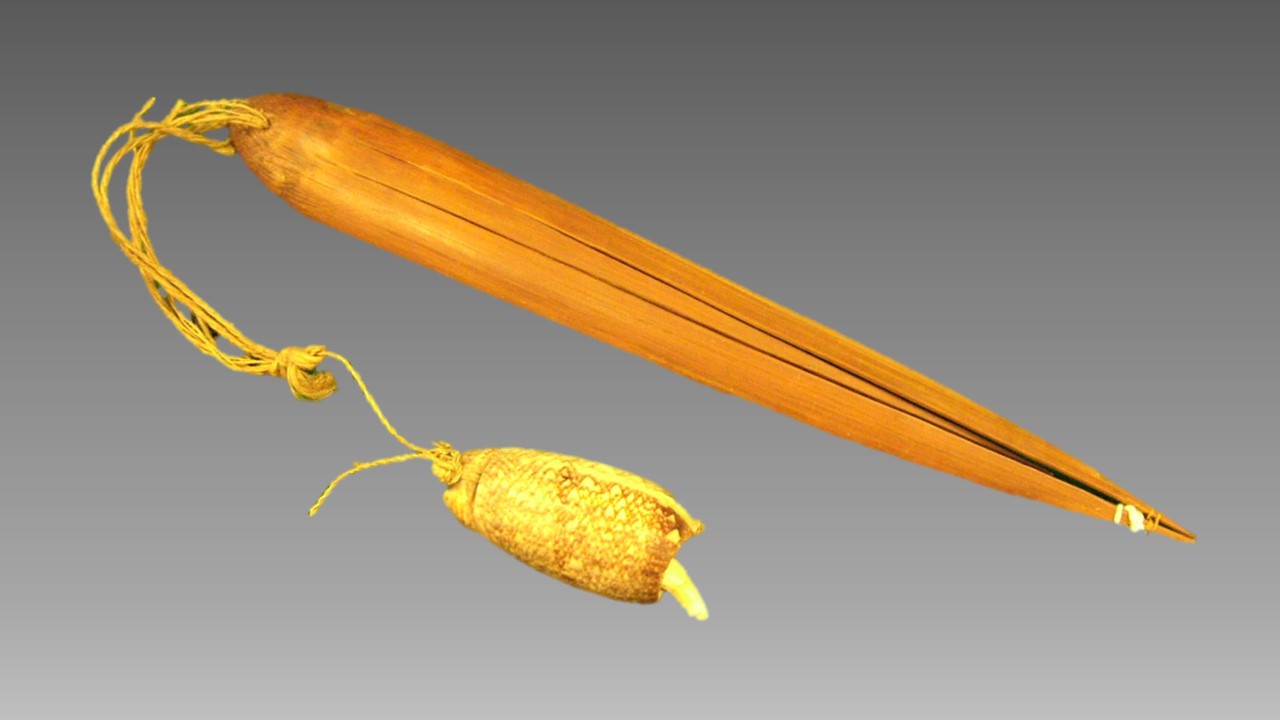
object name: rooria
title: Rooria?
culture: melanesian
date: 1801-1900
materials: bamboo, fiber, shell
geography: papua new guinea